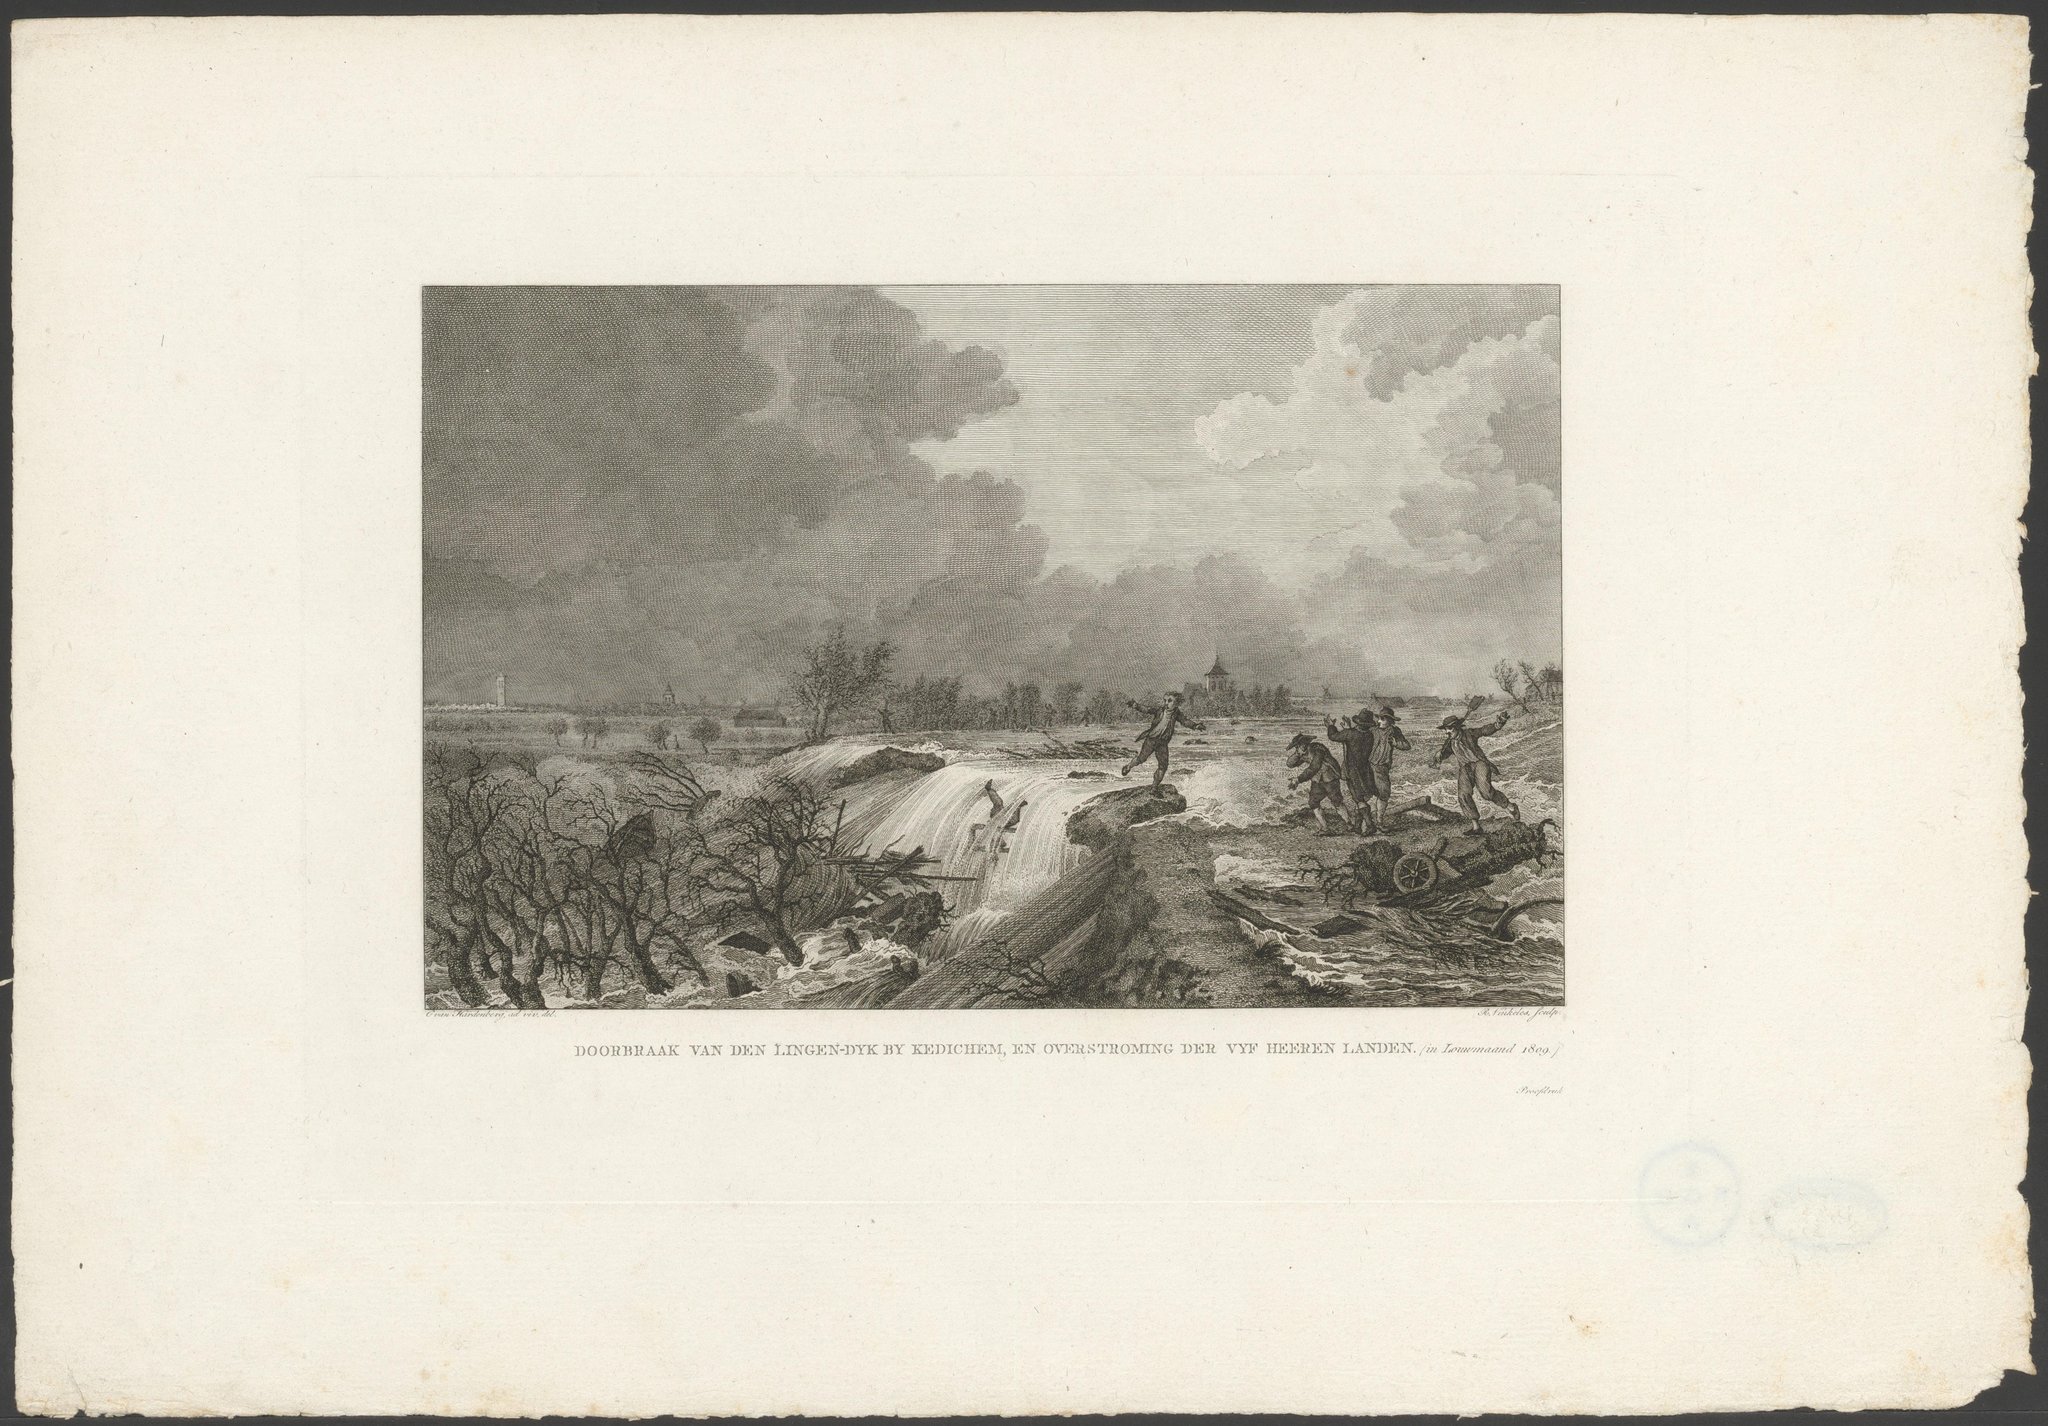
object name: print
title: Dijkdoorbraak bij Kedichem, 1809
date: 1809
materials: paper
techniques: engraving, etching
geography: kedichem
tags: dike-break, flood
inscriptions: stamp, collector's mark: Lugt 1641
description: Prent ook gebruikt ter illustratie van: Ewijk, Hendrik. Geschiedkundig verslag der dijkbreuken en overstroomingen, langs de rivieren in het Koningrijk Holland, voorgevallen in louwmaand MDCCCIX. 3 dln. Amsterdam: Johannes Allart en Jacobus Ruys, 1809.